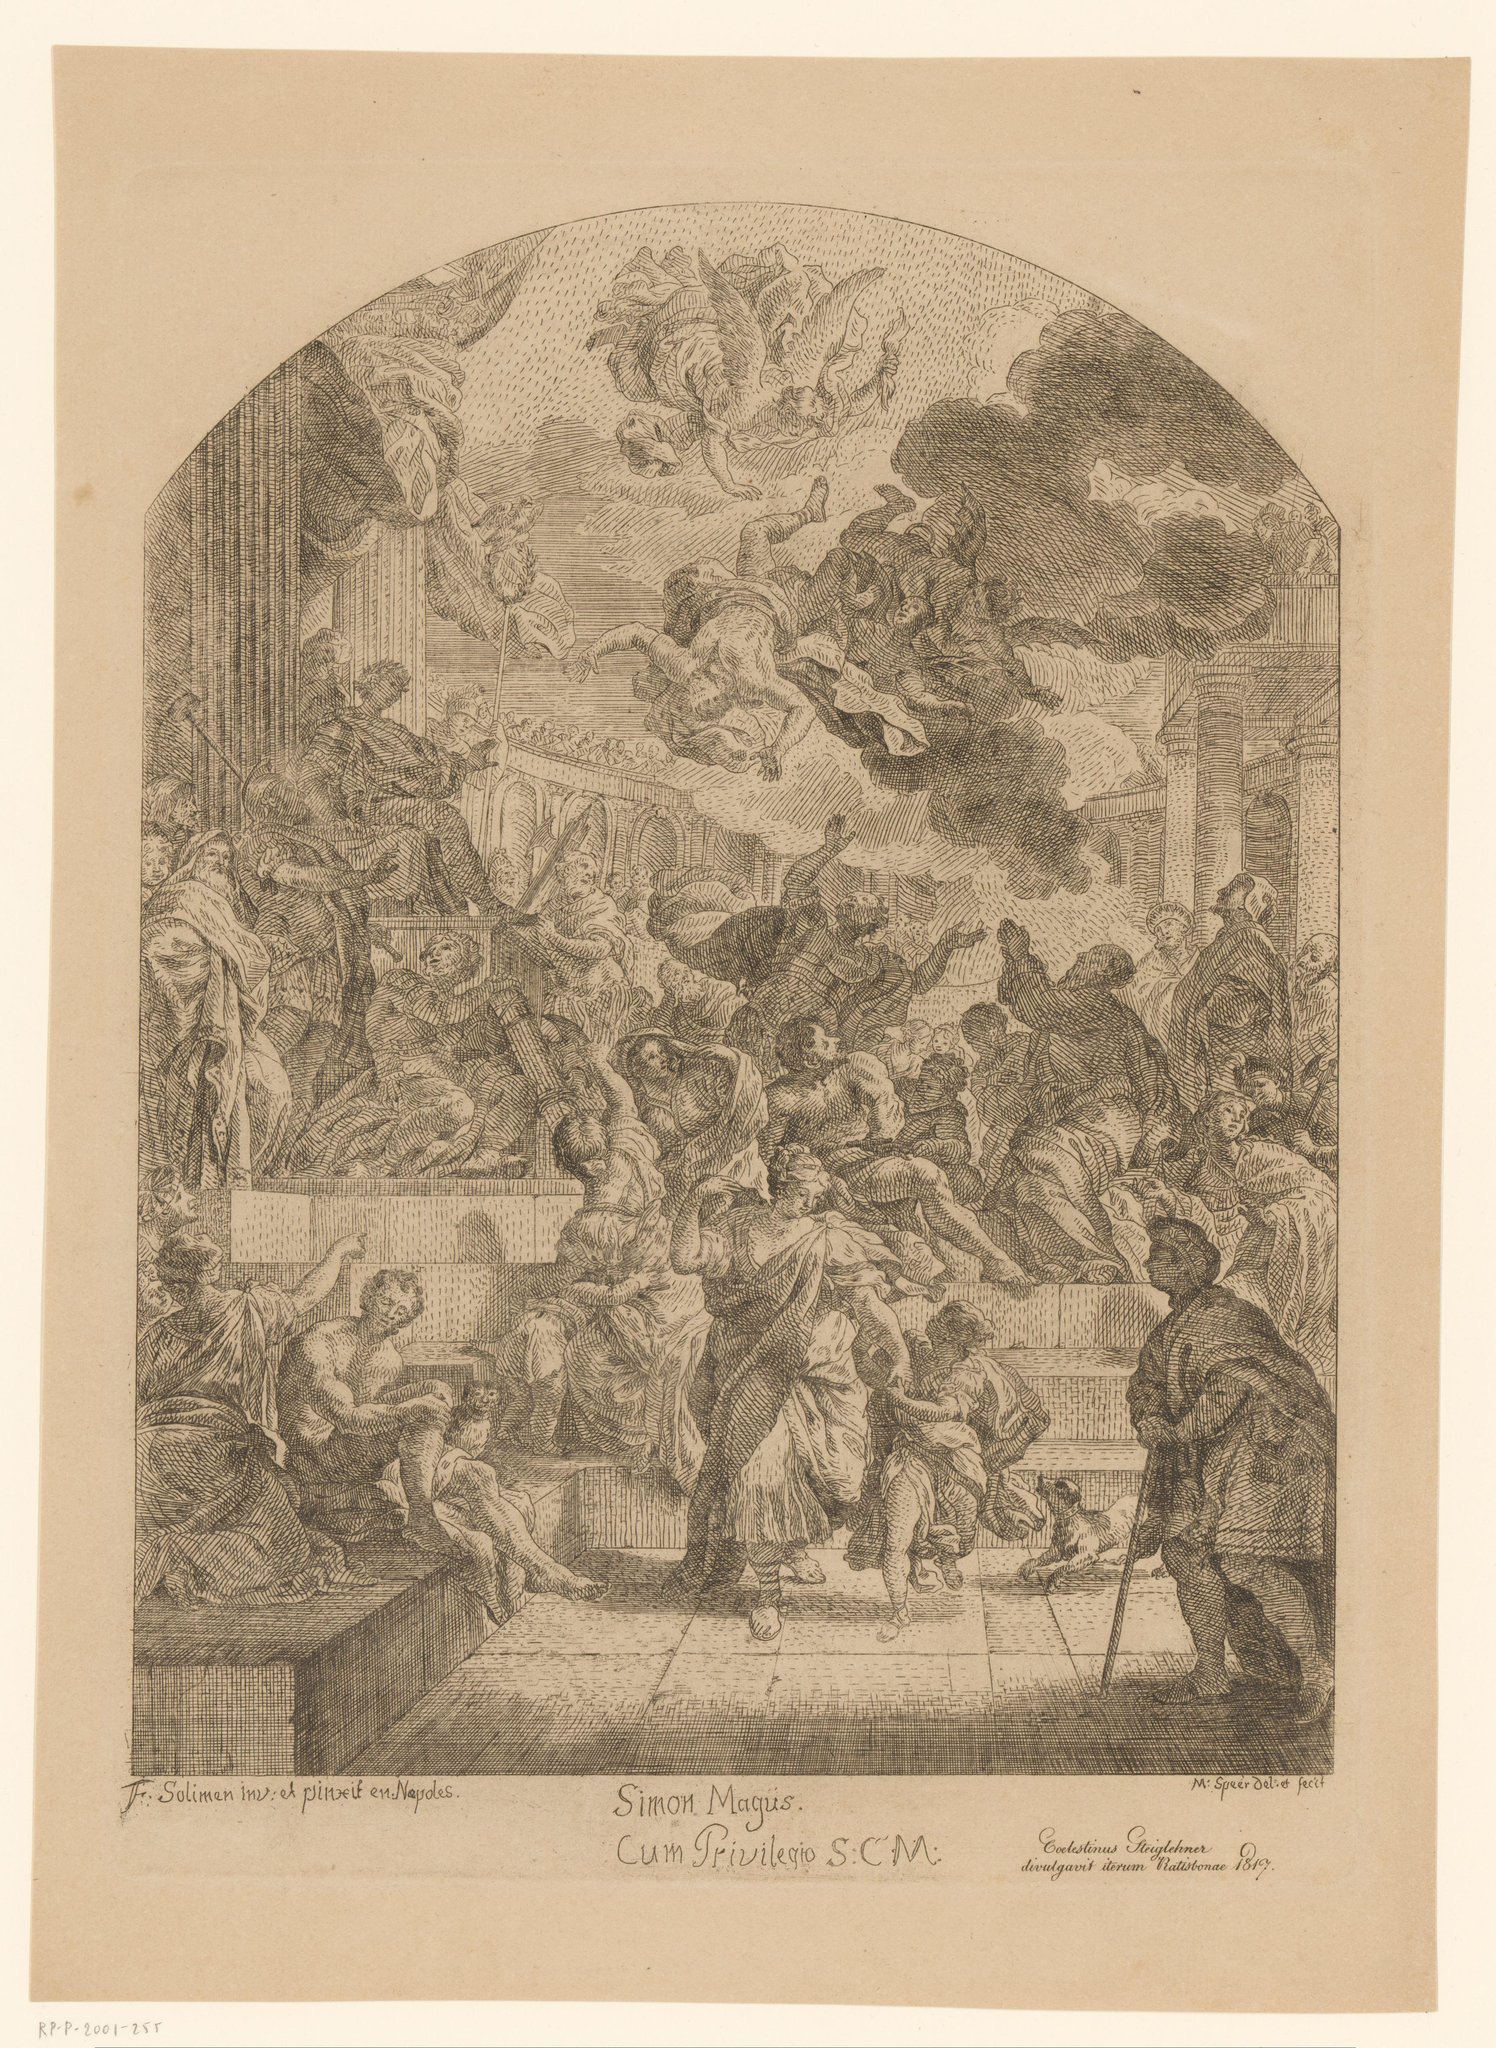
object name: print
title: Simon Magus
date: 1817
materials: paper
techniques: etching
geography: regensburg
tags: peter prays: simon falls down and dies afterwards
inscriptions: collector's mark: Lugt 2228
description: Prent naar de schildering in de Sacrestia di Solimena in de San Paolo Maggiore te Napels.